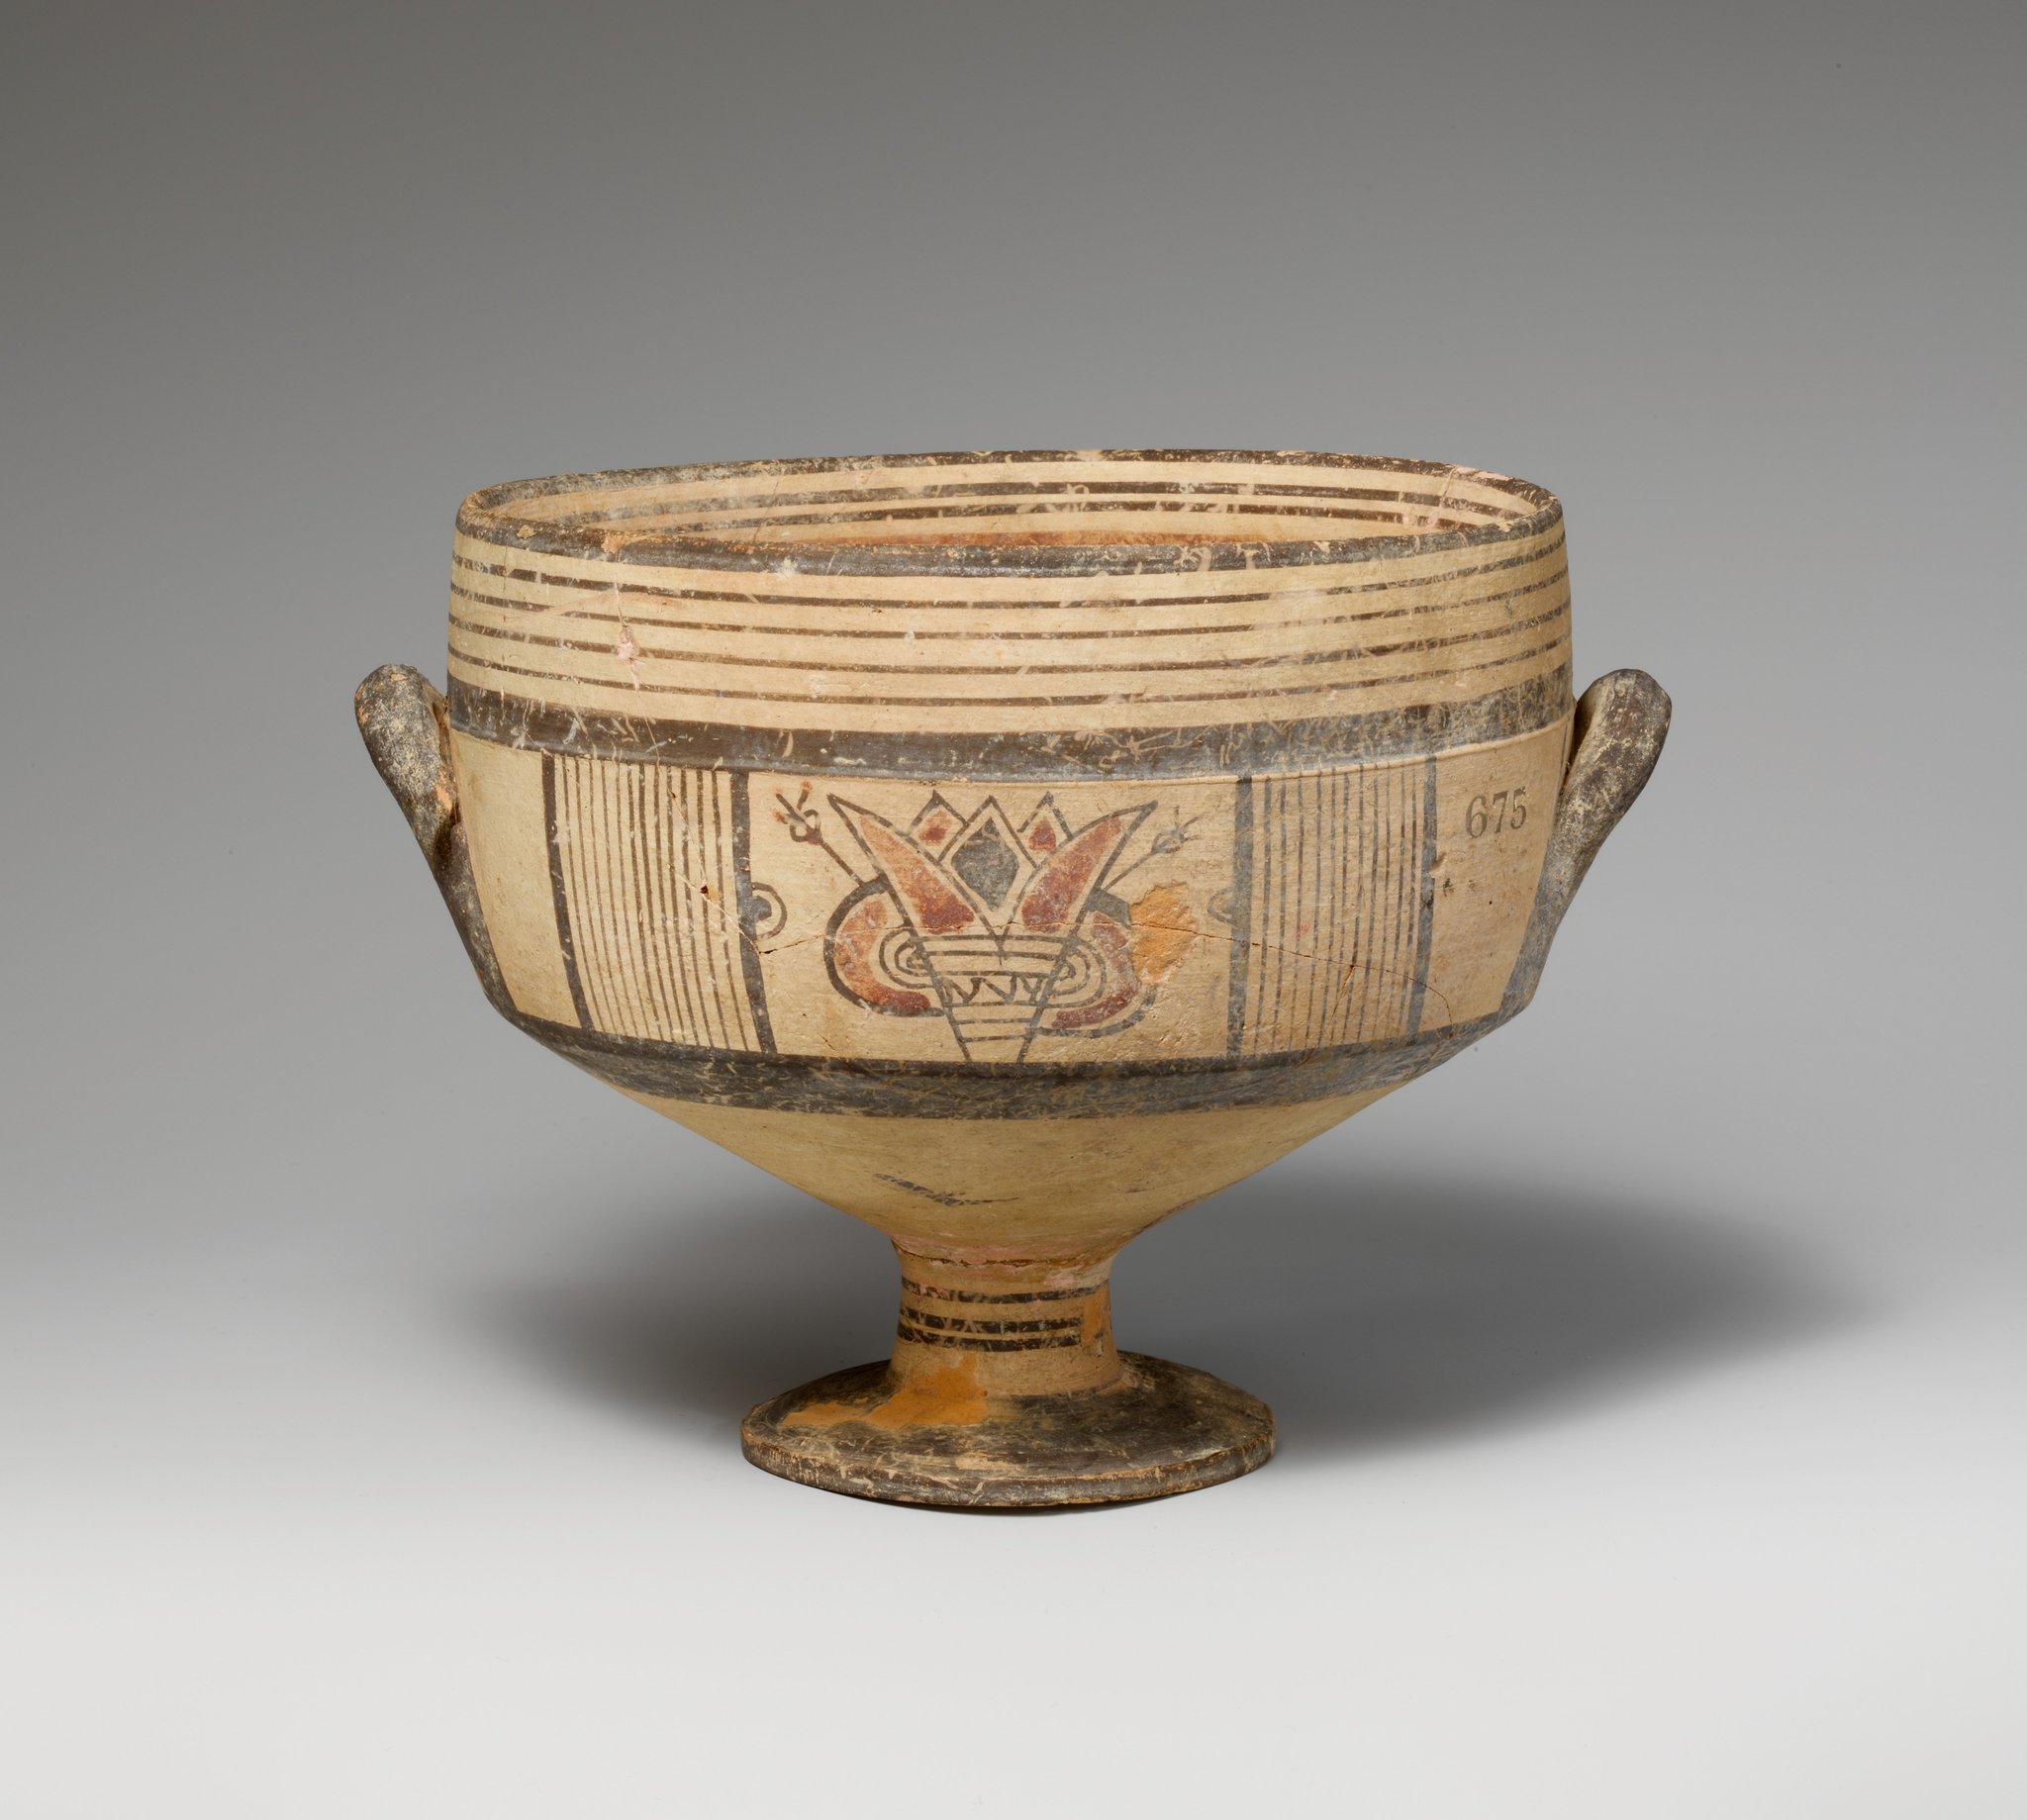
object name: kylix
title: Terracotta footed bowl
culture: cypriot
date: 750-600 BCE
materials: terracotta